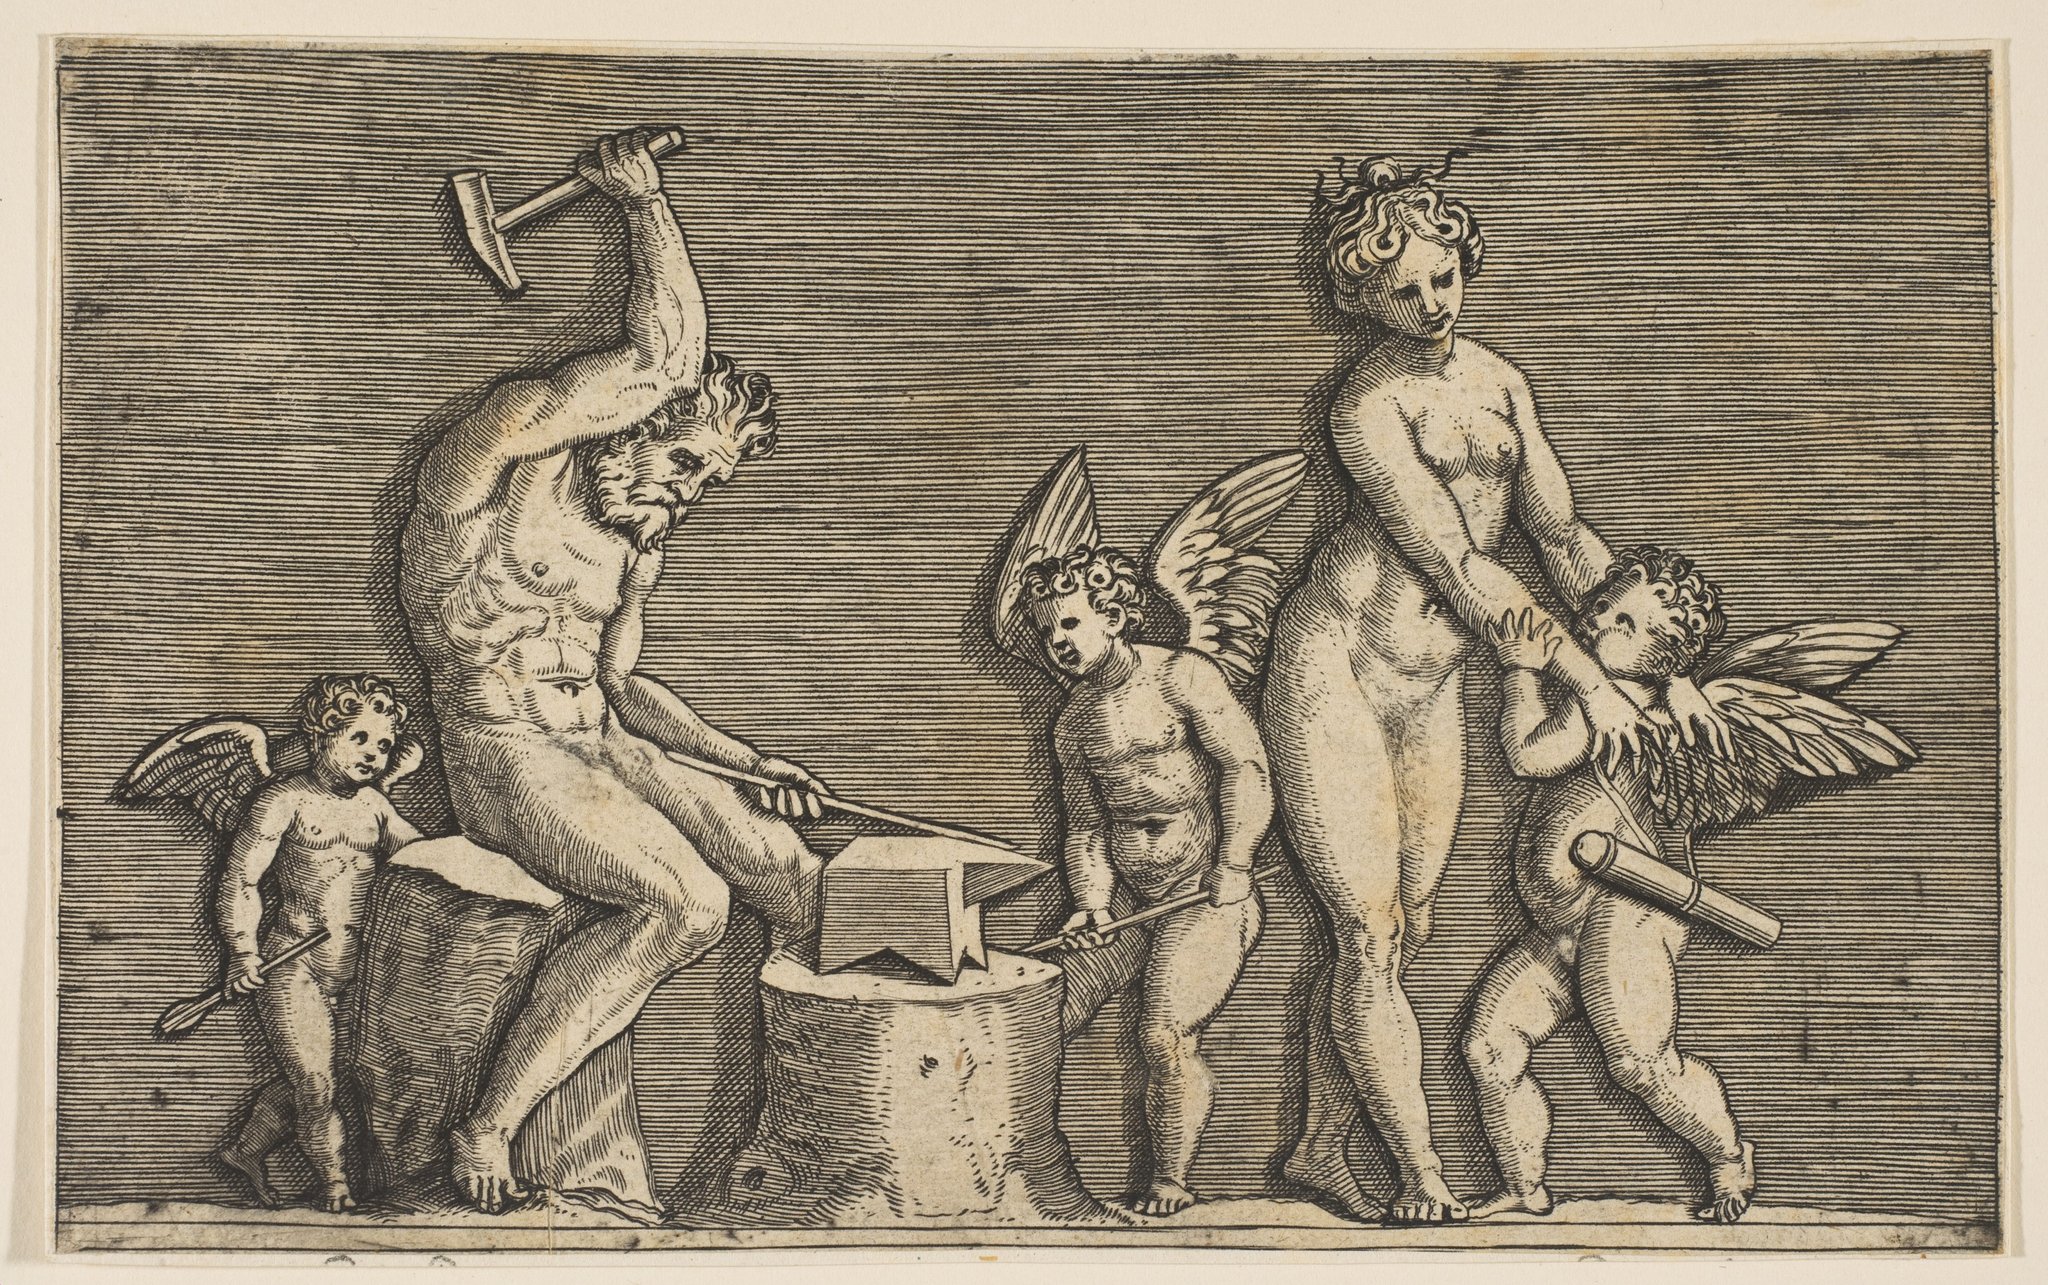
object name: print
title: Vulcan seated hammering on an anvil flanked by Venus and three cupids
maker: marco dente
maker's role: artist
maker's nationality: italian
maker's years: 1515-1527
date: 1515-1527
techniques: engraving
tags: cupid,venus,vulcan,working,hammers